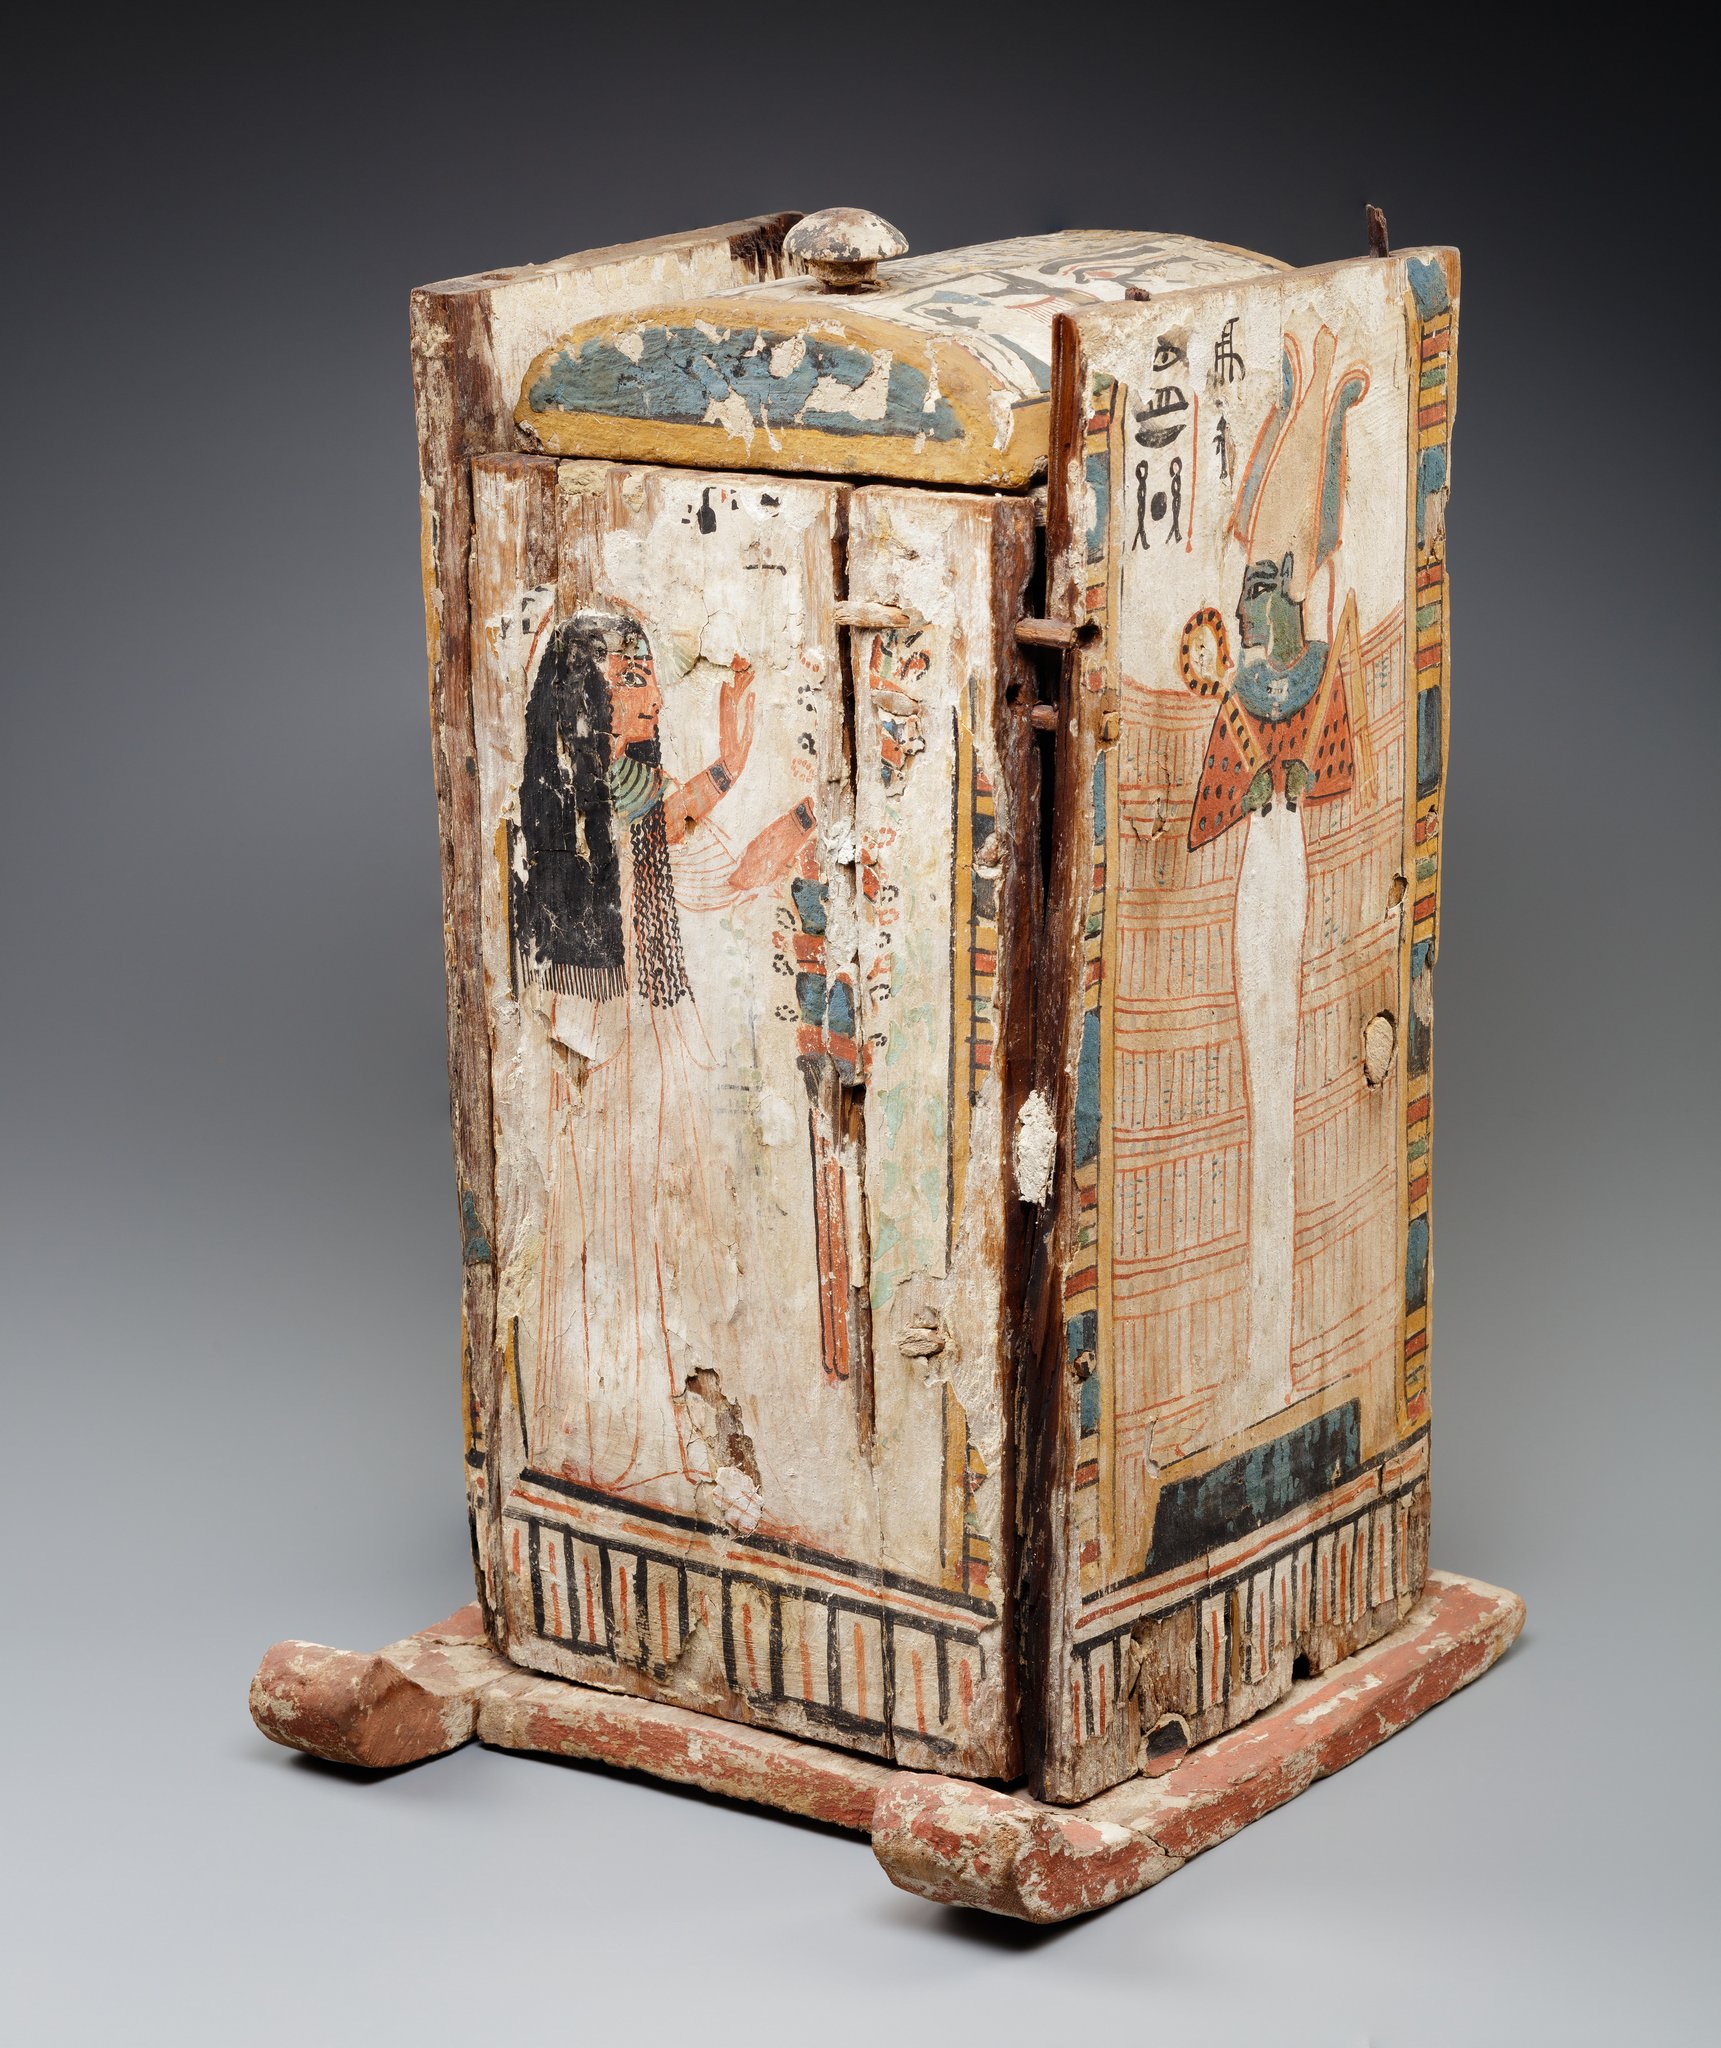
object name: shabti box, miya, singer of thoth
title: Shabti Box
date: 1295-1070 BCE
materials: gesso, paint, wood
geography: egypt